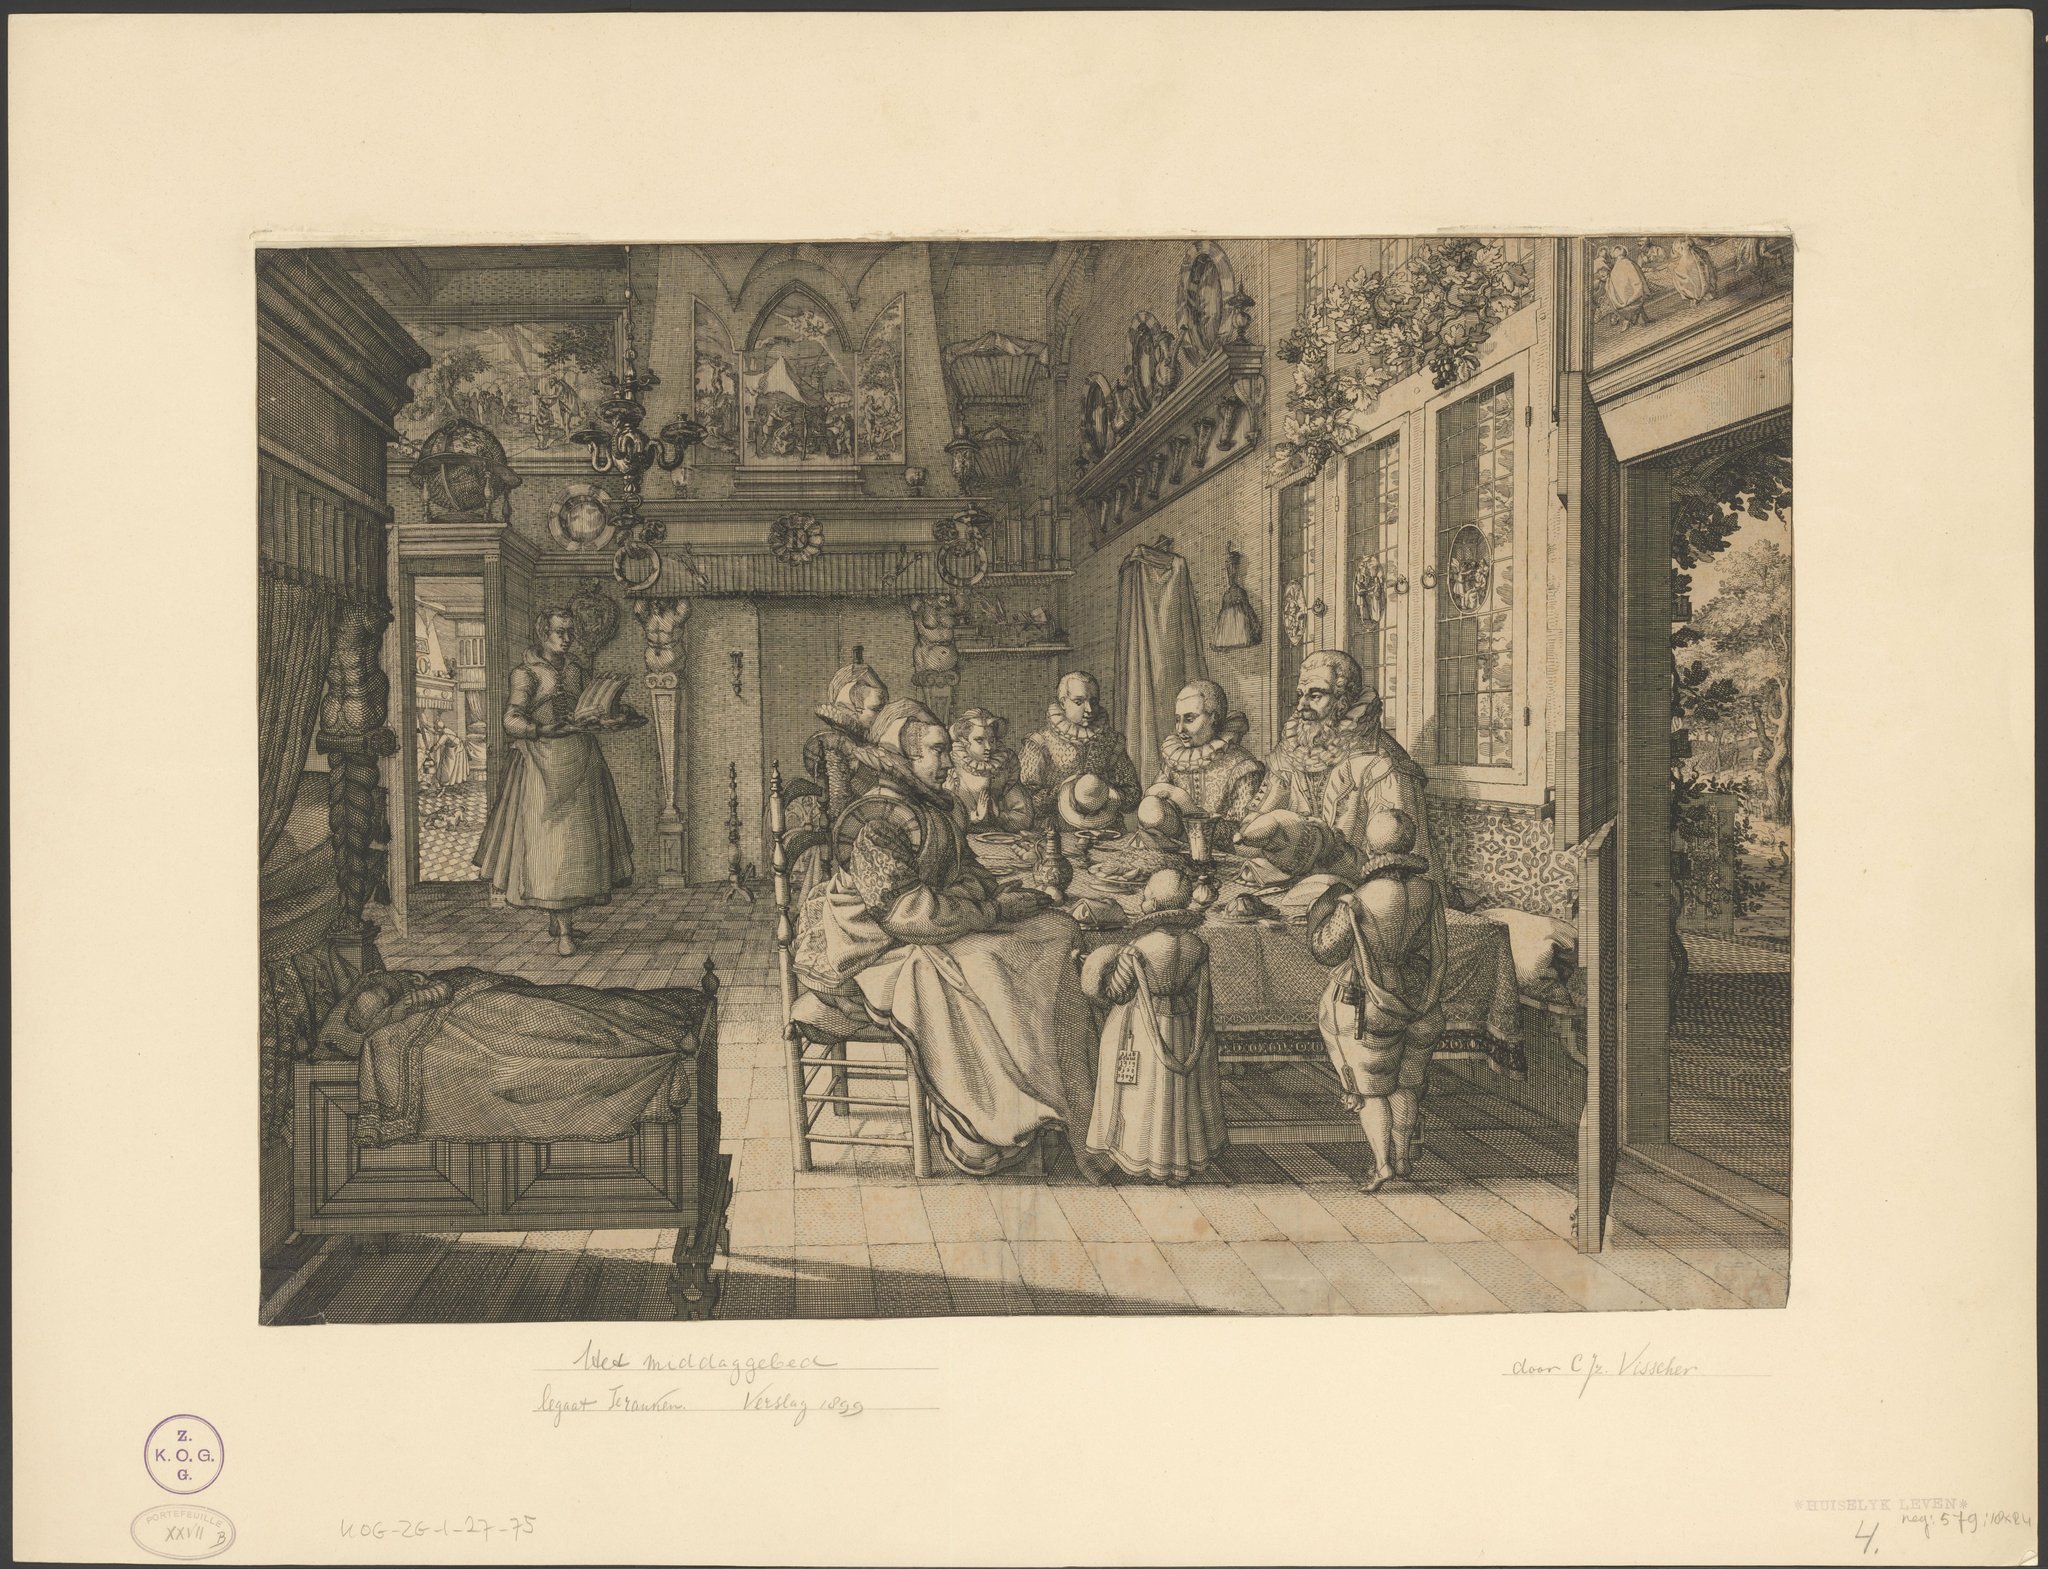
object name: print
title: Gebed voor de maaltijd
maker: claes jansz. visscher (ii)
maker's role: draughtsman, print maker, publisher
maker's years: 1586-1652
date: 1609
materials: paper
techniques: engraving, etching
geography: amsterdam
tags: cradle, crib, family life at home, picture, painting, prayer at table, saying grace, globe, kitchen-maid, kitchen servant, dining-room, bunch of grapes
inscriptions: collector's mark:, collector's mark: Lugt 1641, collector's mark: Lugt 963